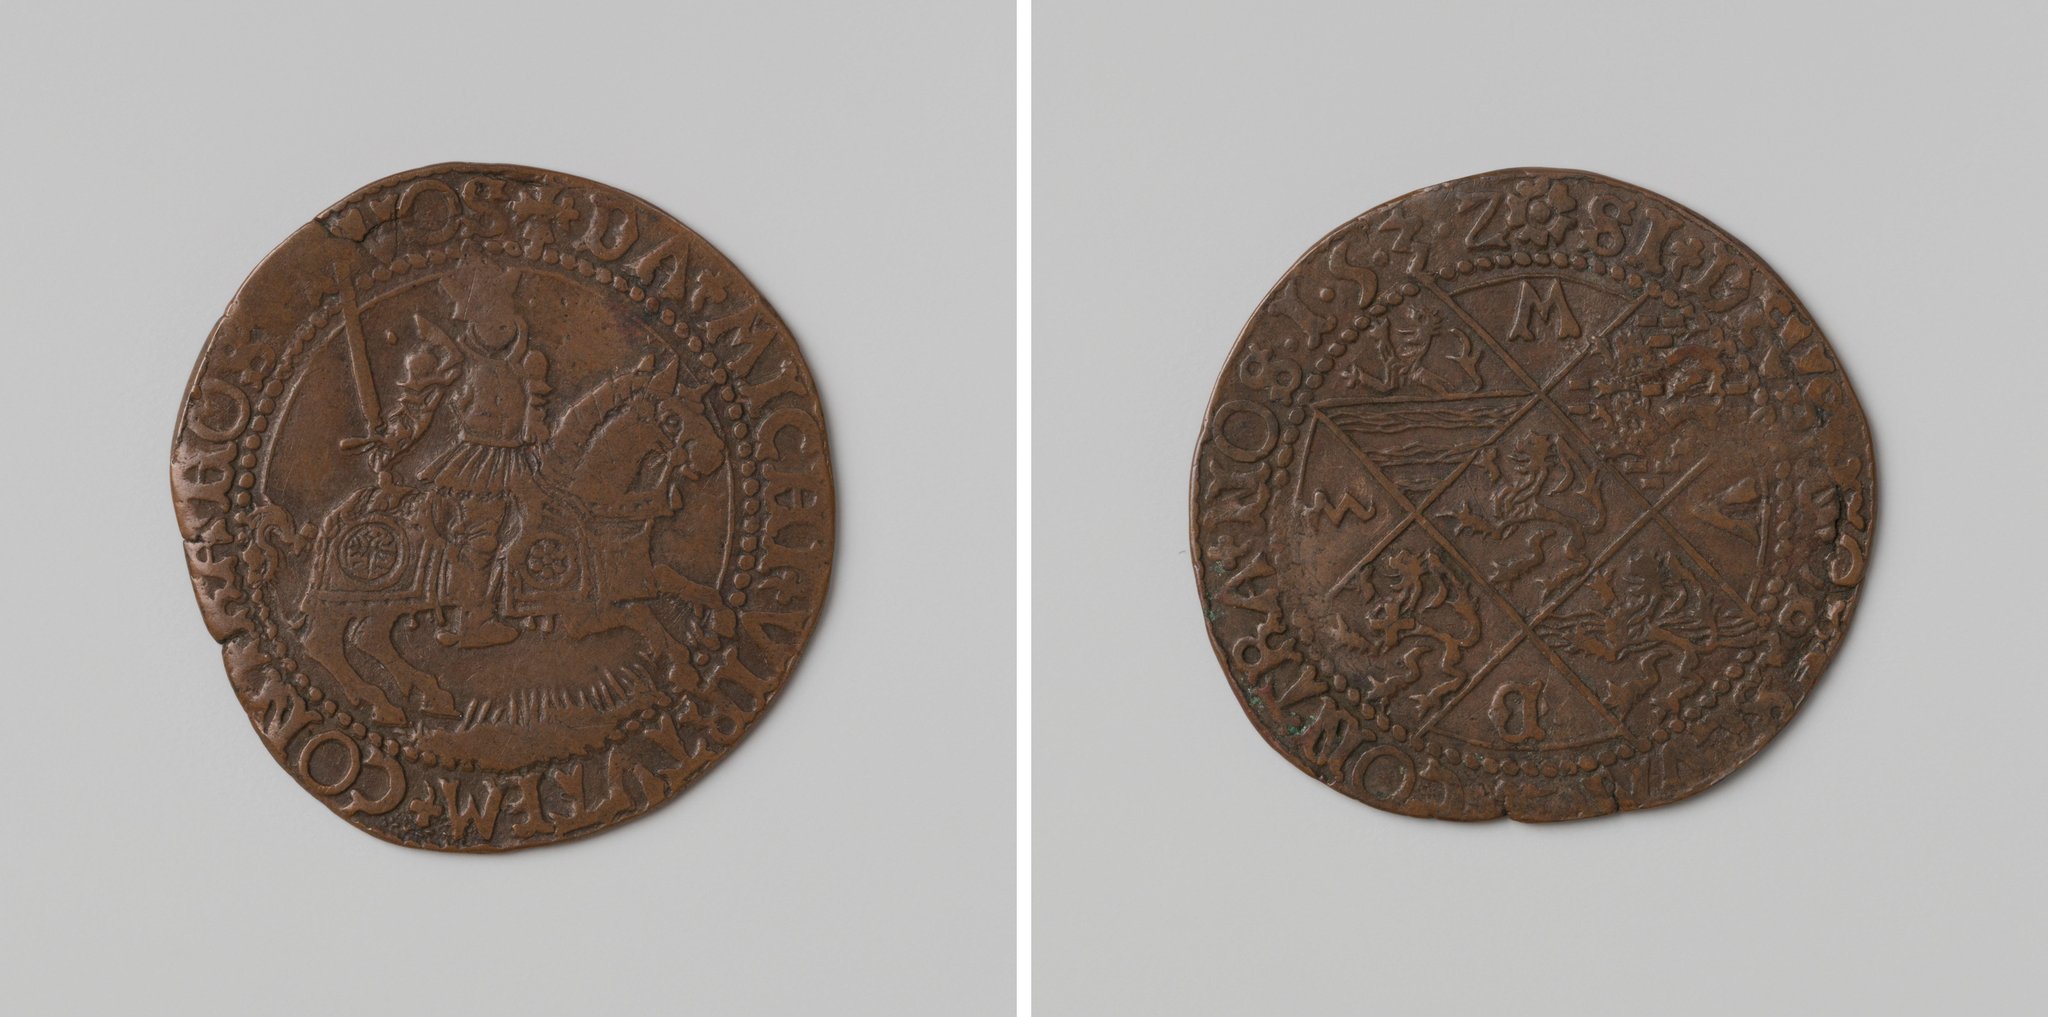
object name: jeton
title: Karel V, Duits keizer, bereidt zich voor op de oorlog tegen de Turken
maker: Anonymous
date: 1532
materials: copper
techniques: striking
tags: ghent, charles v (holy roman emperor and king of spain)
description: Koperen penning. Voorzijde: Karel V te paard, met kroon op hoofd en getrokken zwaard in rechterhand binnen omschrift. Keerzijde: vijf in diagonaal kruis geplaatste wapenschilden; daartussen: letters M, V, C en Z binnen omschrift